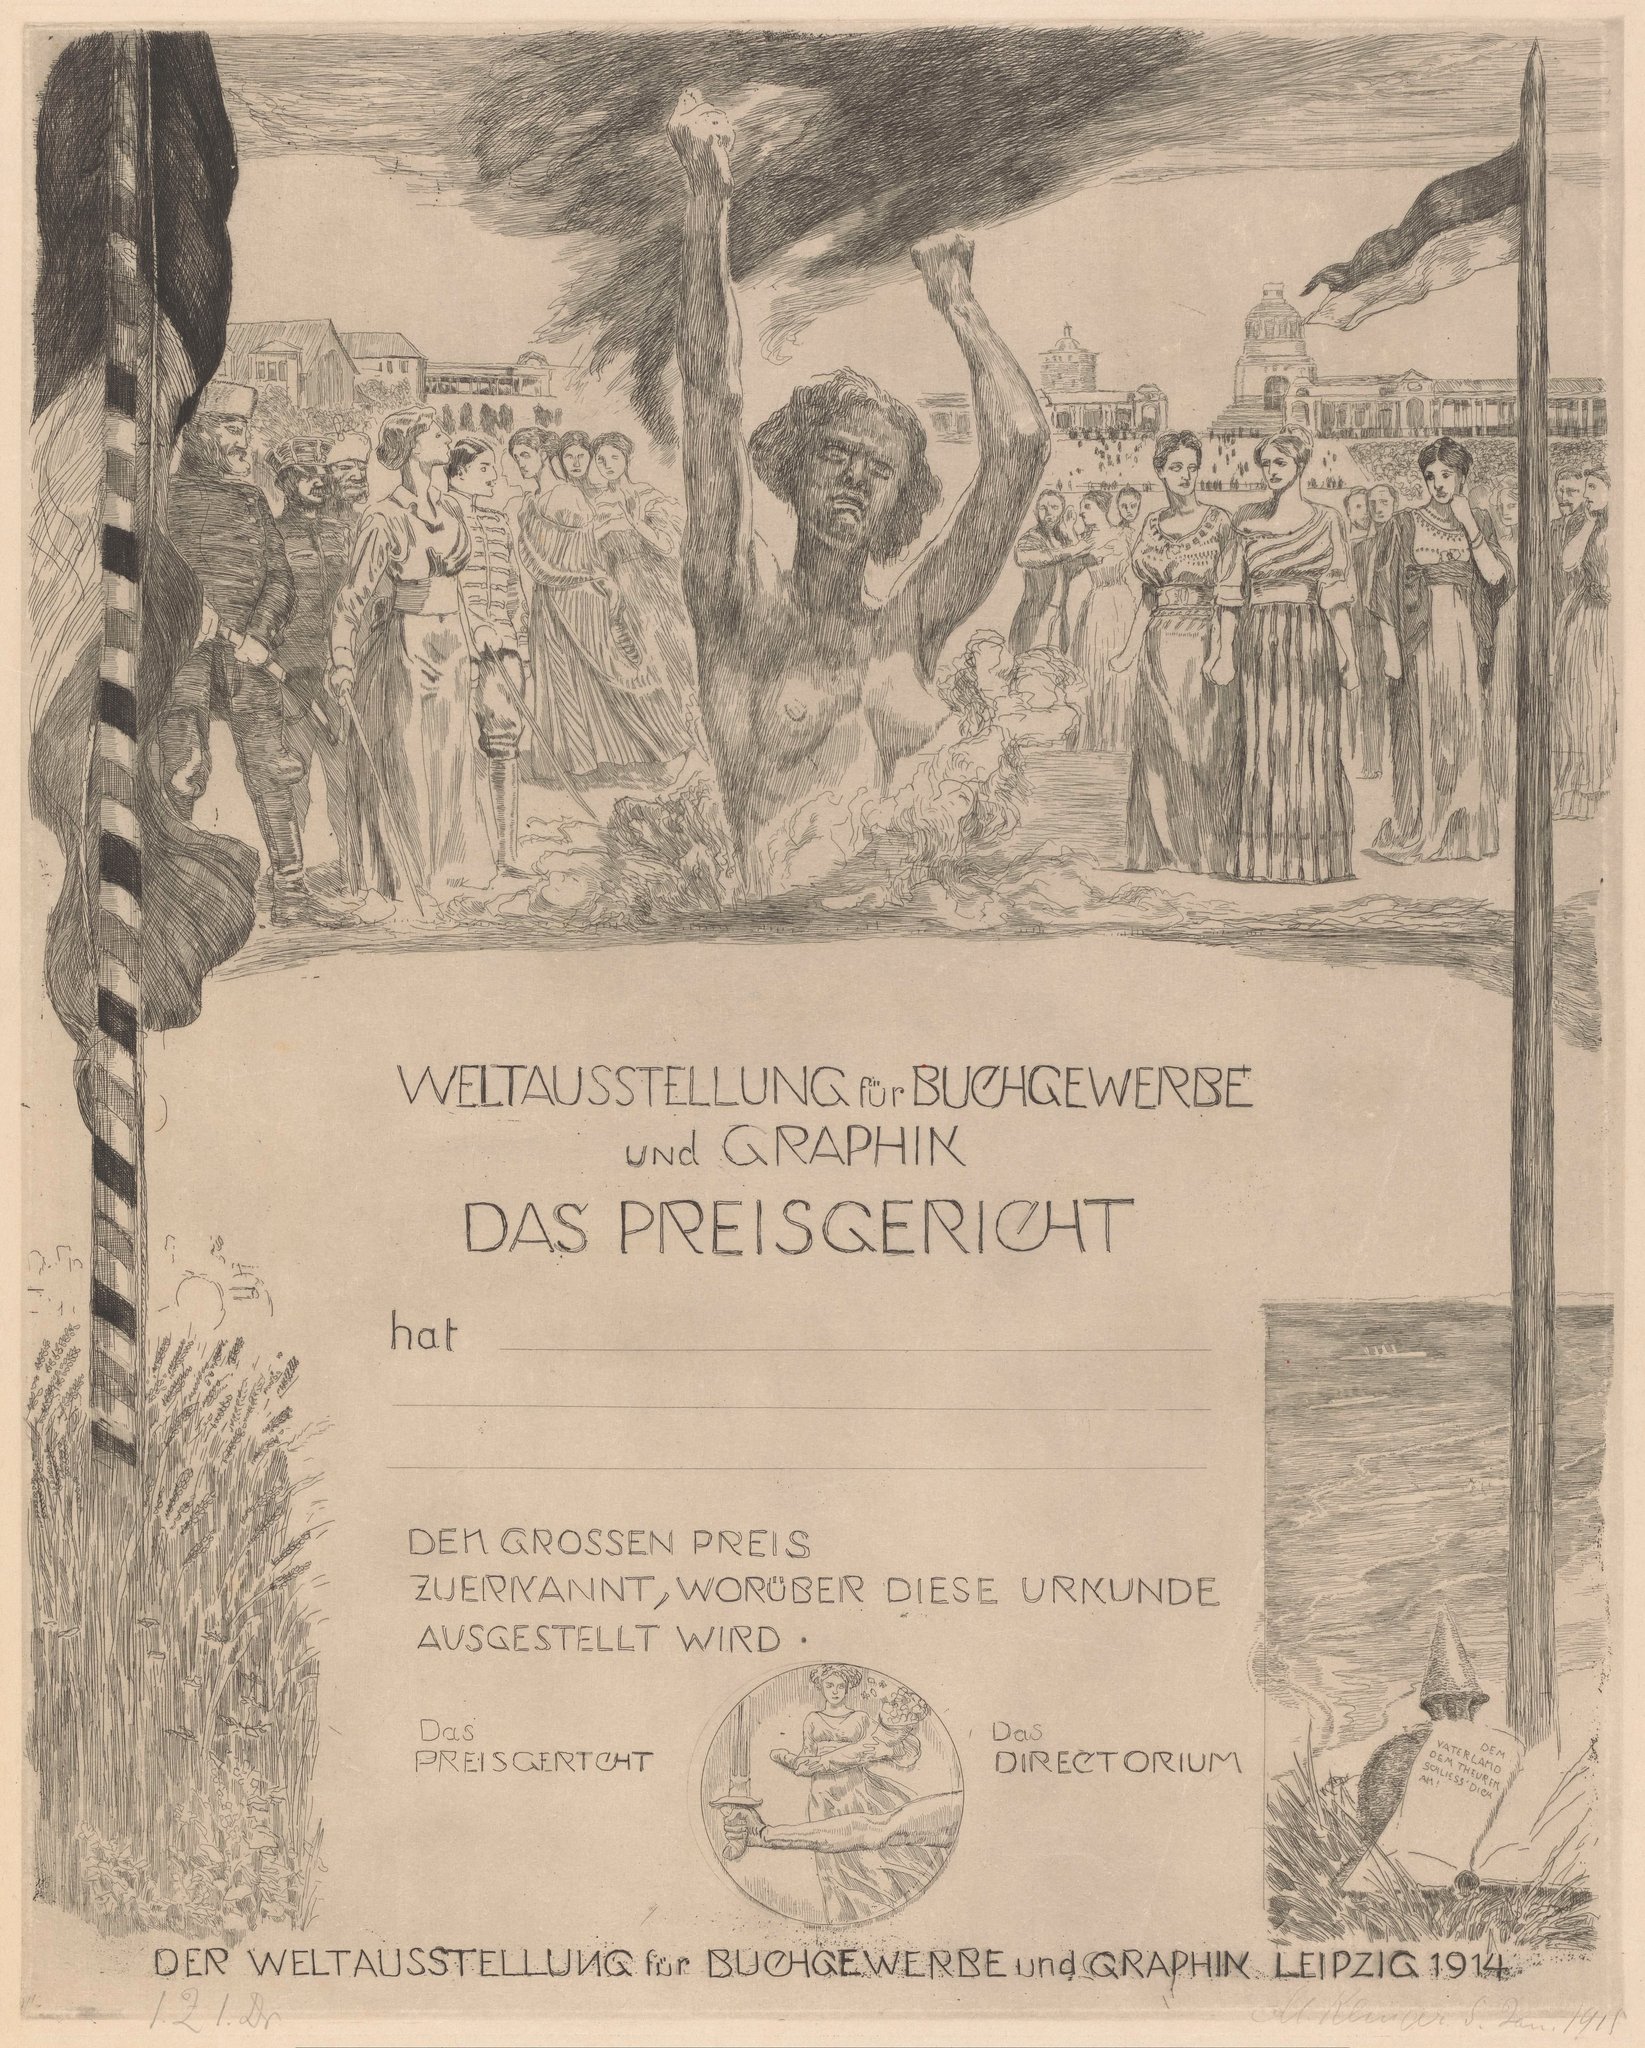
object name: print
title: Oorkonde van de Internationale Tentoonstelling voor Boeknijverheid en Grafiek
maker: max klinger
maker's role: print maker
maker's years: 1857-1920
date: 1915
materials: paper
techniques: etching, intaglio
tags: world fair, world exhibition, flagpole, medal (considered as a piece of sculpture, regardless of its specific function), cereal, grain, corn (grass with grains, grown for food, e.g.: wheat, rice, rye, oats, maize, buckwheat, millet), the (nude) human figure; 'corpo humano' (ripa) - aa - female human figure, sea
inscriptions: annotation: ‘1. Zustand; 1. Druck, v.d. Landschaft unter der Fahne links. Slg. Dr. H. Stinnes, Lugt 1746a’, collector's mark: Lugt 1376a, collector's mark: Lugt 4780, inscription: ‘1.Z 1.Dr’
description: Oningevulde oorkonde bedoelt voor prijswinnaars op de 'Weltausstellung für Buchgewerbe und Graphik' gehouden te Leipzig in 1914. Boven een naakte vrouw die met gebalde vuisten uit het water omhoog komt. Achter haar figuren uit verschillende landen met in de achtergrond het festivalterrein. Onder een afbeelding van de medaille met daarop een arm met een zwaard en een vrouw met een hoorn des overvloeds in haar handen. Links en rechts een vlaggenmast. Rechtsonder een opengeslagen boek met een citaat van Friedrich von Schiller.